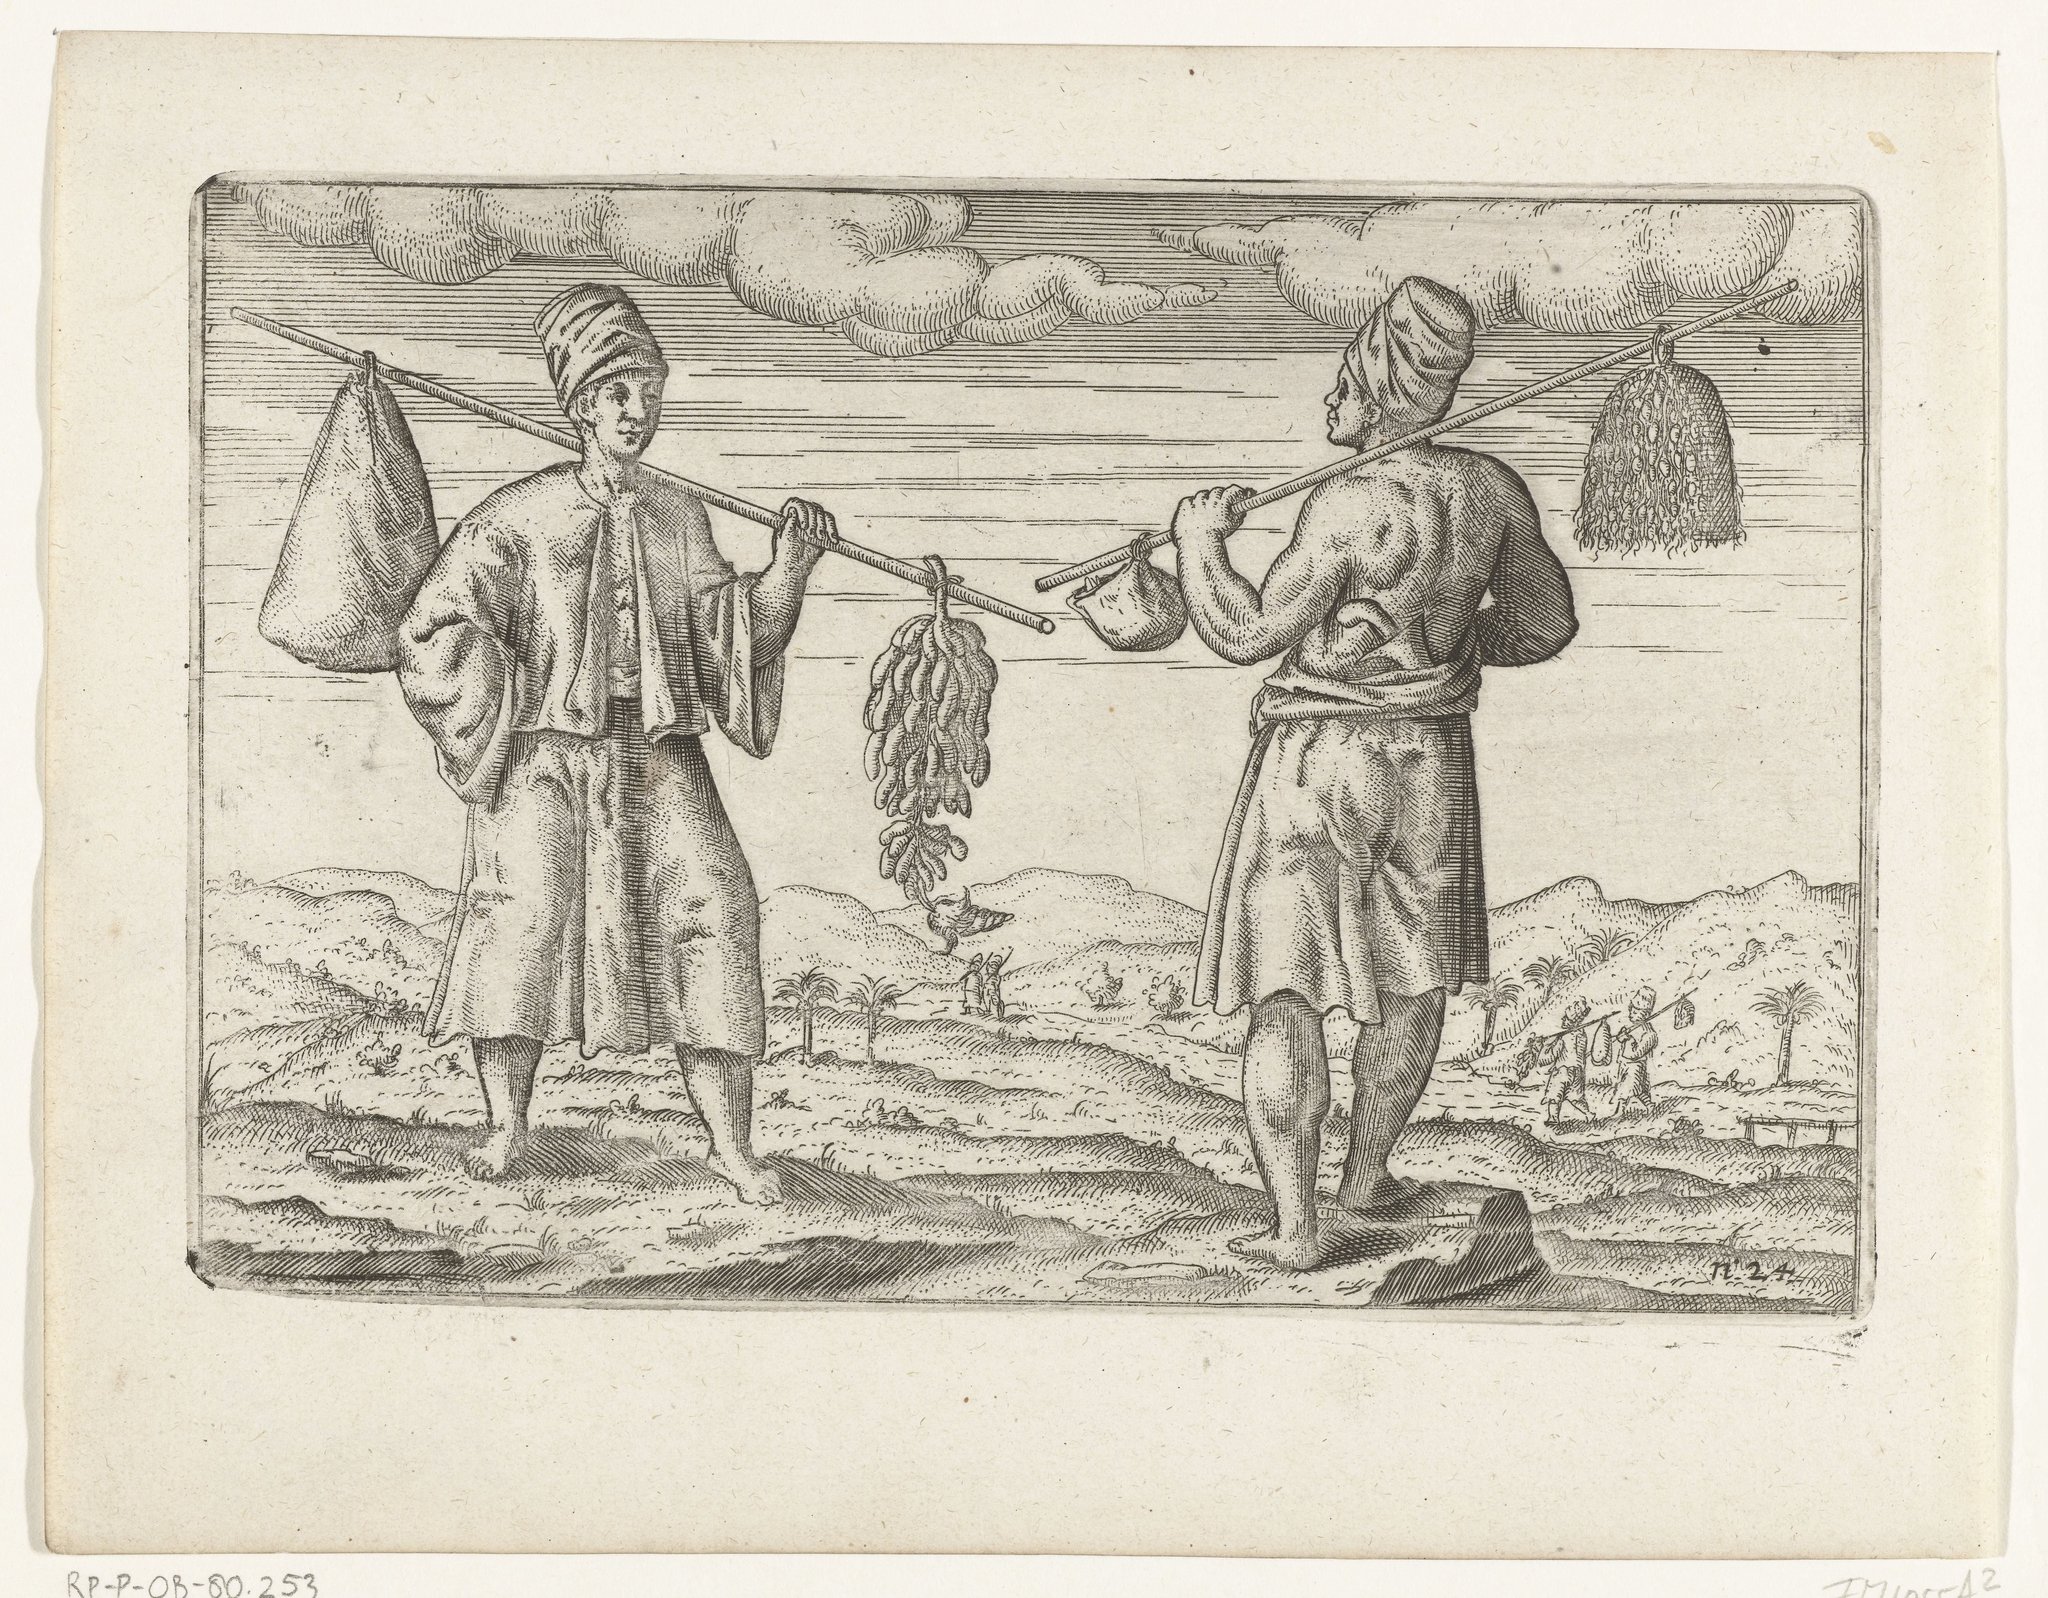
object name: print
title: Landlieden van achter Bantam, 1596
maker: Anonymous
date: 1597-1598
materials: paper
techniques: engraving, etching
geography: northern netherlands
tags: gouda, landscapes in tropical and sub-tropical regions, exploration, expedition, voyage of discovery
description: Gebruikt als illustratie eerst in: Willem Lodewijcksz, D'eerste boeck. Historie van Indien, waer inne verhaelt is de avontueren die de Hollandtsche schepen bejeghent zijn, Cornelis Claes, Amsterdam 1598. In deze opgewerkte staat gebruikt in: De Eerste Schipvaerd der Hollandsche Natie naer Oost-Indien, waer inne verhaelt wordt al wat haer sonderlings onder wegen bejegent is ... ghetrocken uyt verscheyden Iournalen ofte dagh-registers daer van ghemaeckt, zeer vermaeckelijck ende nut om lesen. Opgenomen in: I. Commelin, Begin ende voortgangh, van de Vereenighde Nederlantsche Geoctroyeerde Oost-Indische Compagnie, J. Janssonius, Amsterdam 1646. Genummerd: 24.